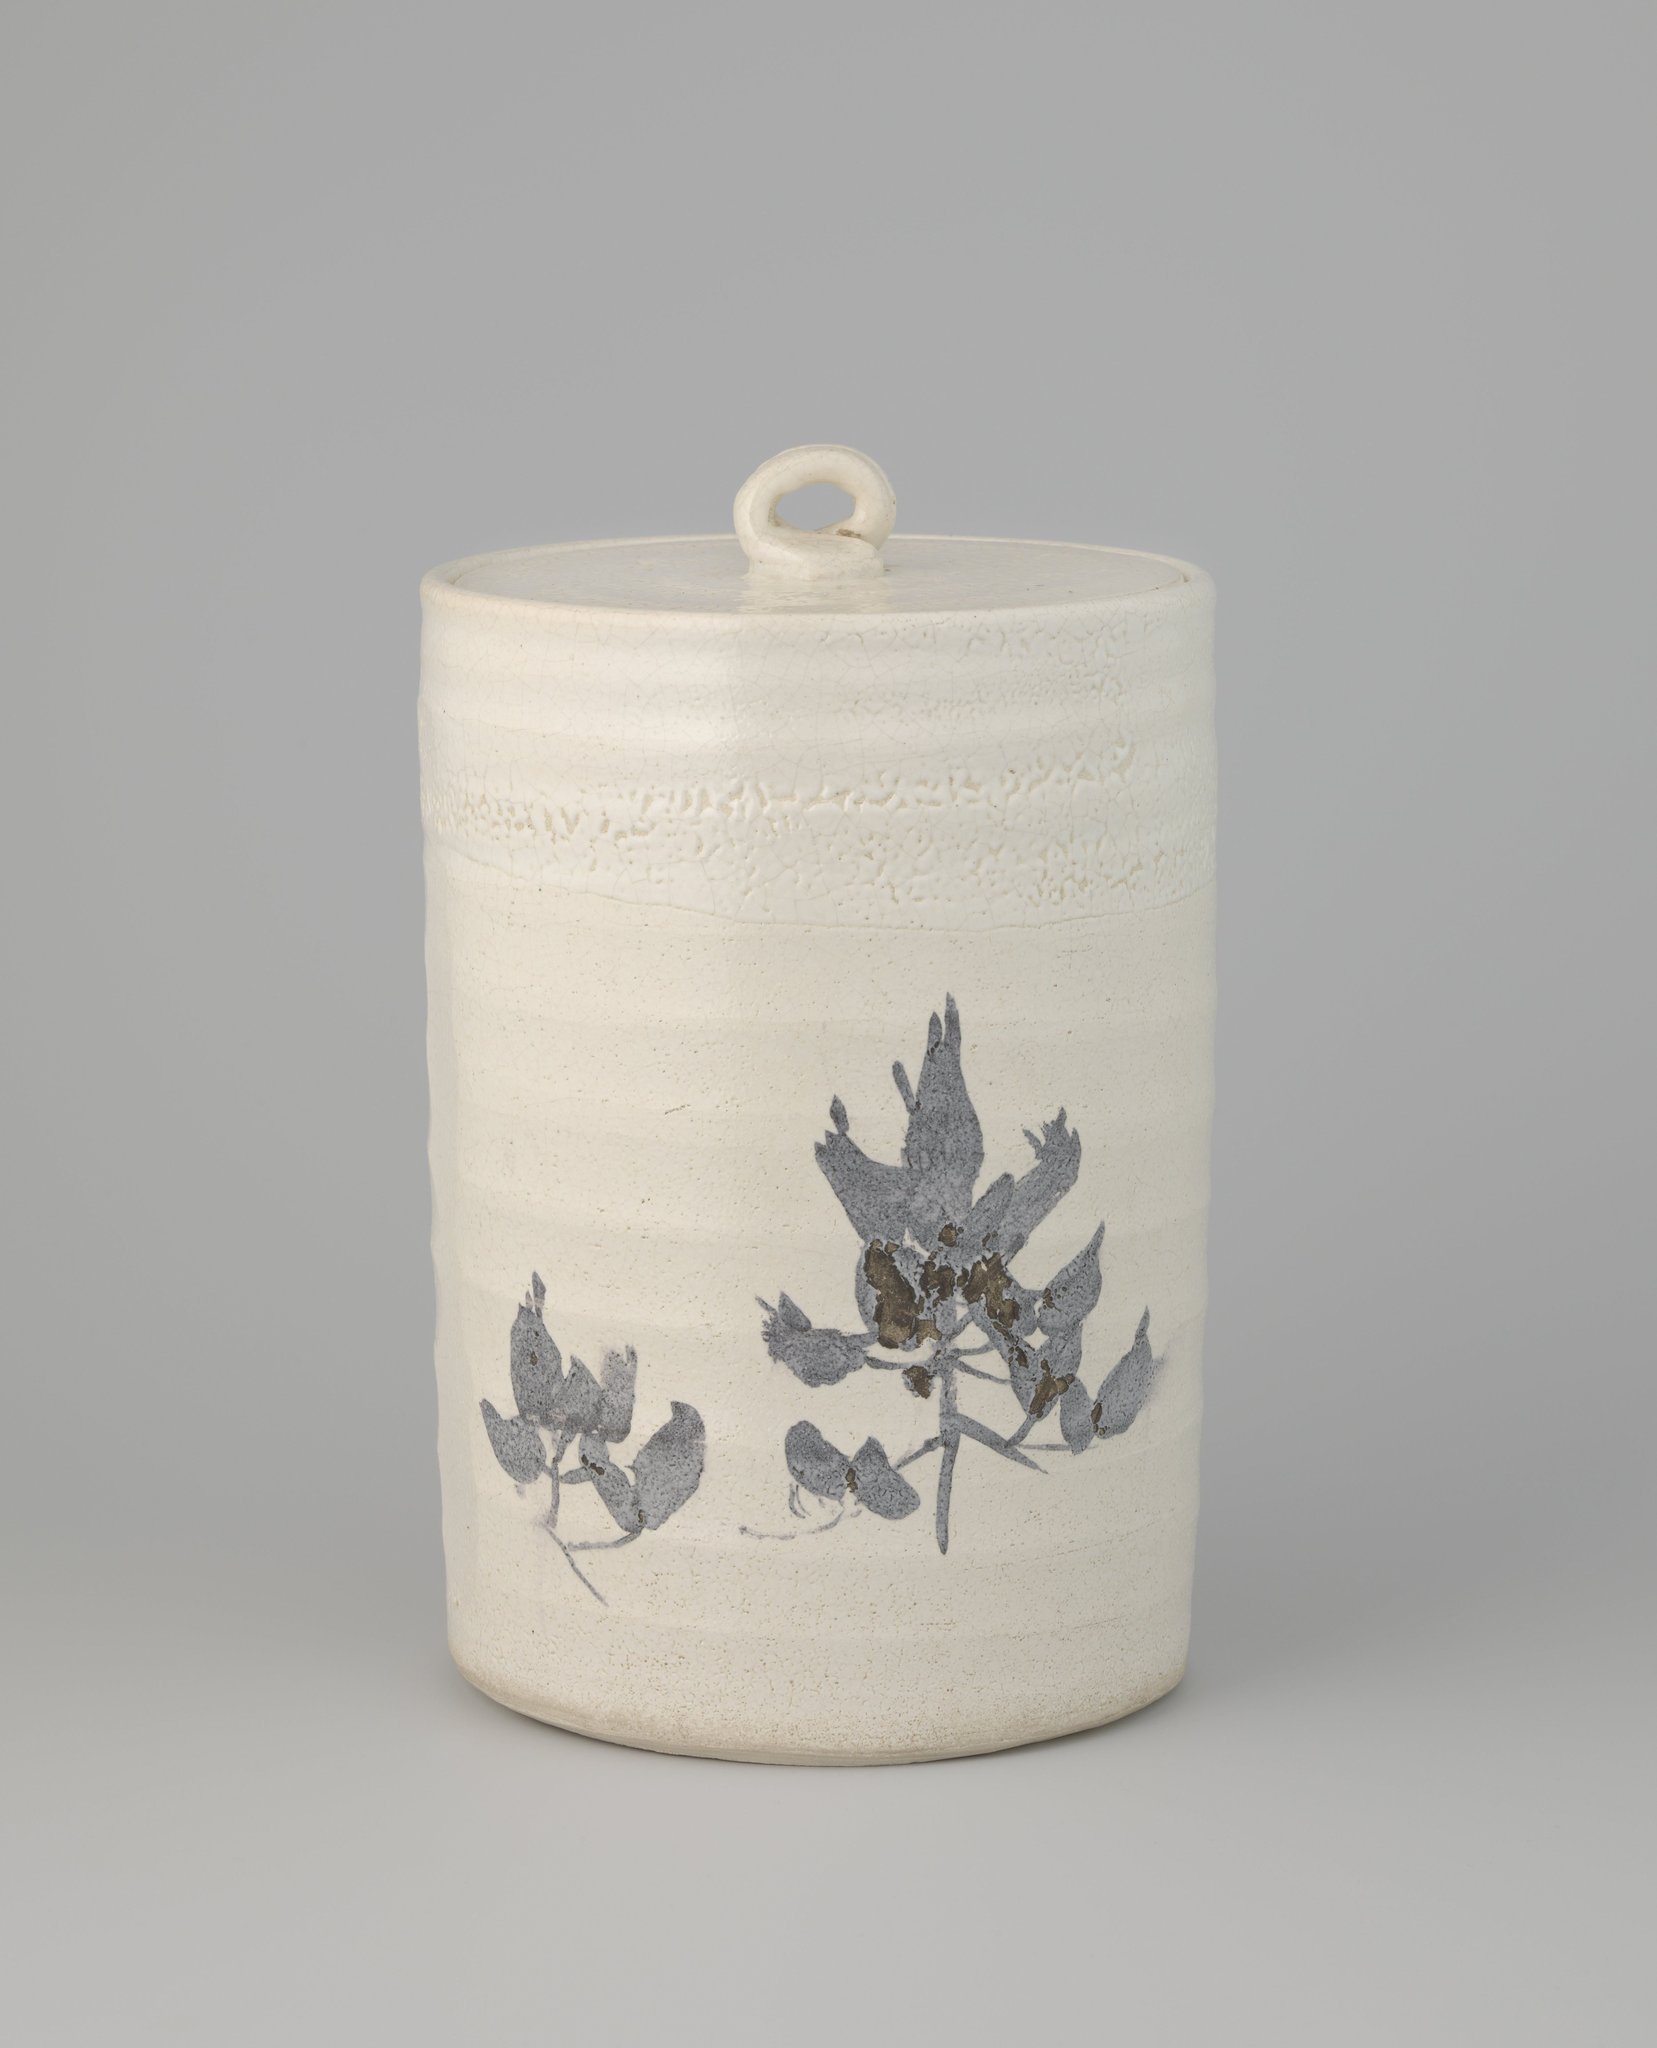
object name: mizusashi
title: Water Pot for the Tea Ceremony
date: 1920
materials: cobalt, glaze, paint, porcelain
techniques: firing, turning, vitrification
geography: japan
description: Ceramists from Kyoto often collaborated with painters, who added the decoration. This water pot was made by an unknown potter and then ornamented by Takeuchi Seiho, a well-known print designer and painter. The young pine branches are a New Year’s motif, so this water pot was intended for a tea ceremony at that time of the year.